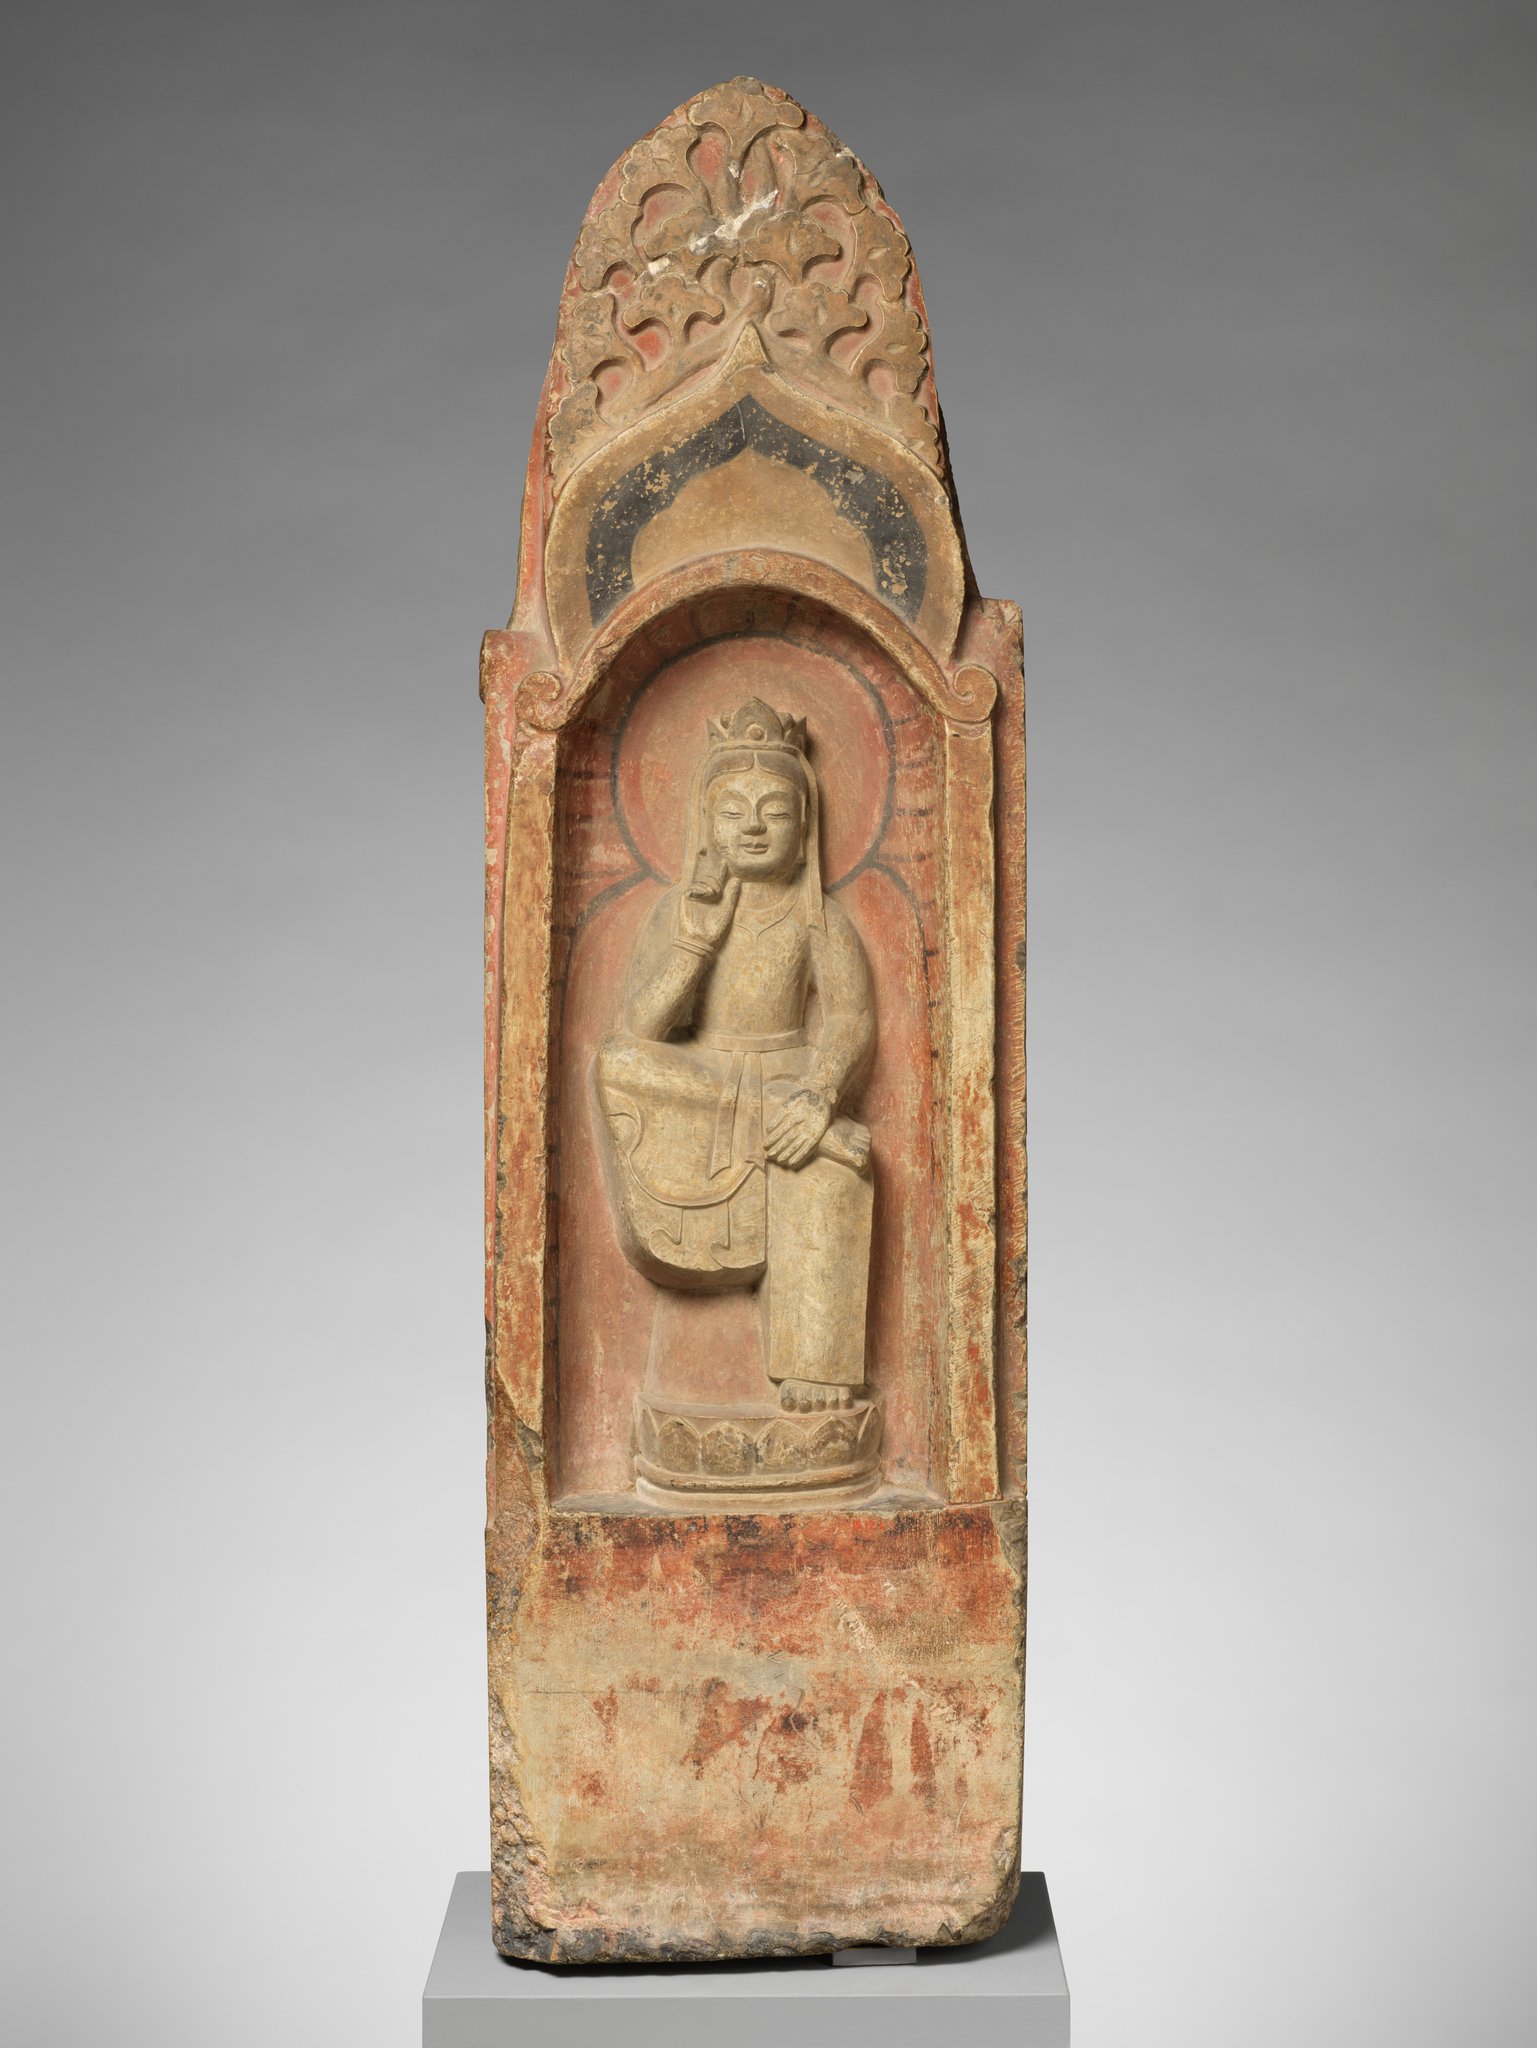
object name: stele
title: Stele with Maitreya (19.12a); Standing bodhisattva (Maitreya?) (19.12b); Standing Buddha (19.12c)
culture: chinese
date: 386-1933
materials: pigment, stone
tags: maitreya